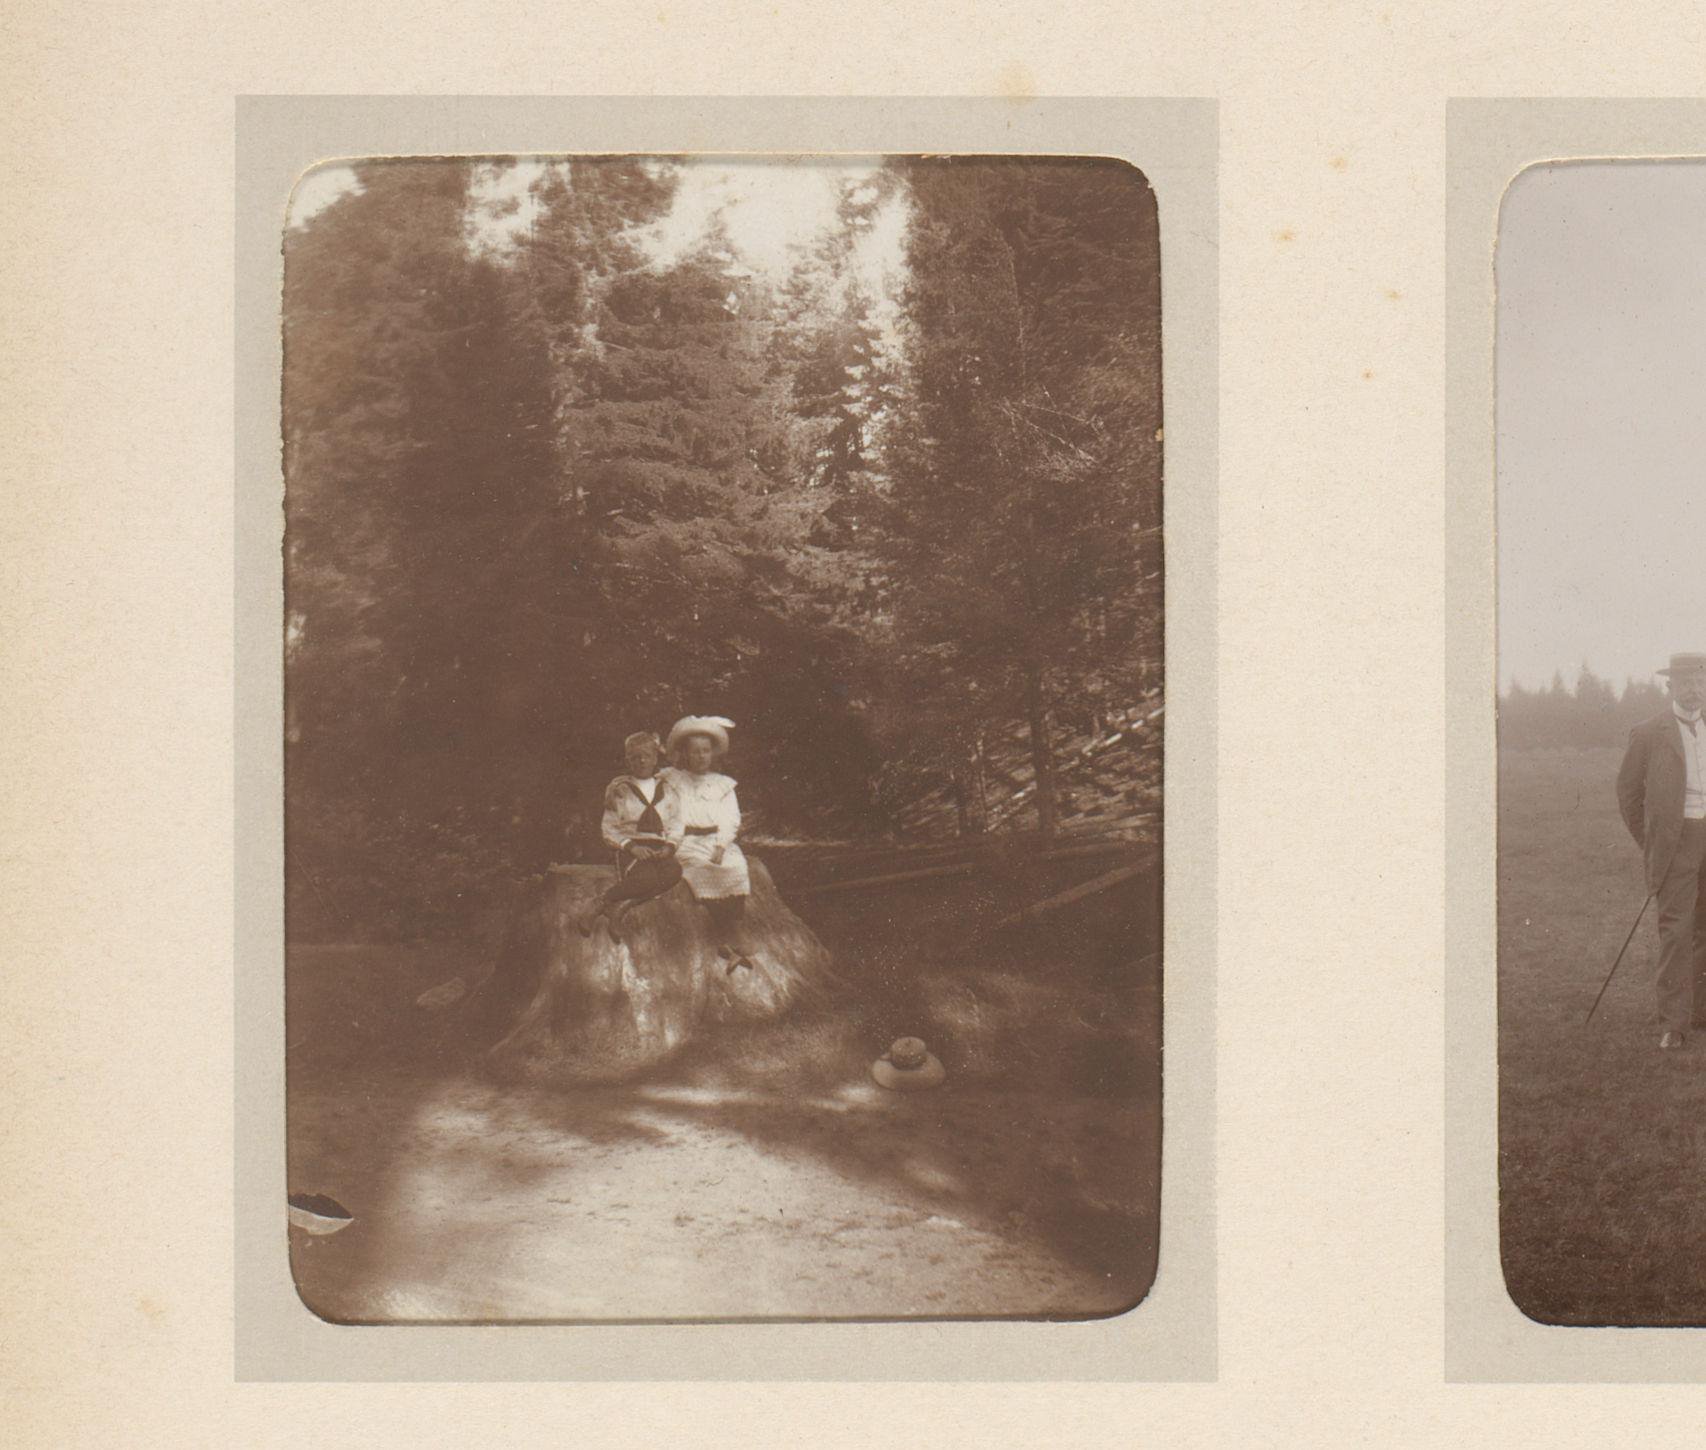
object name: photograph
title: Twee kinderen, zittend op een steen in een bos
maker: liesbeth overhoff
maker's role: fotograaf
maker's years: 1895-1969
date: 1910-1915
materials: paper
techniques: matte daylight collodion silver print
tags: forest, wood, child (+ two persons), boulder, stone